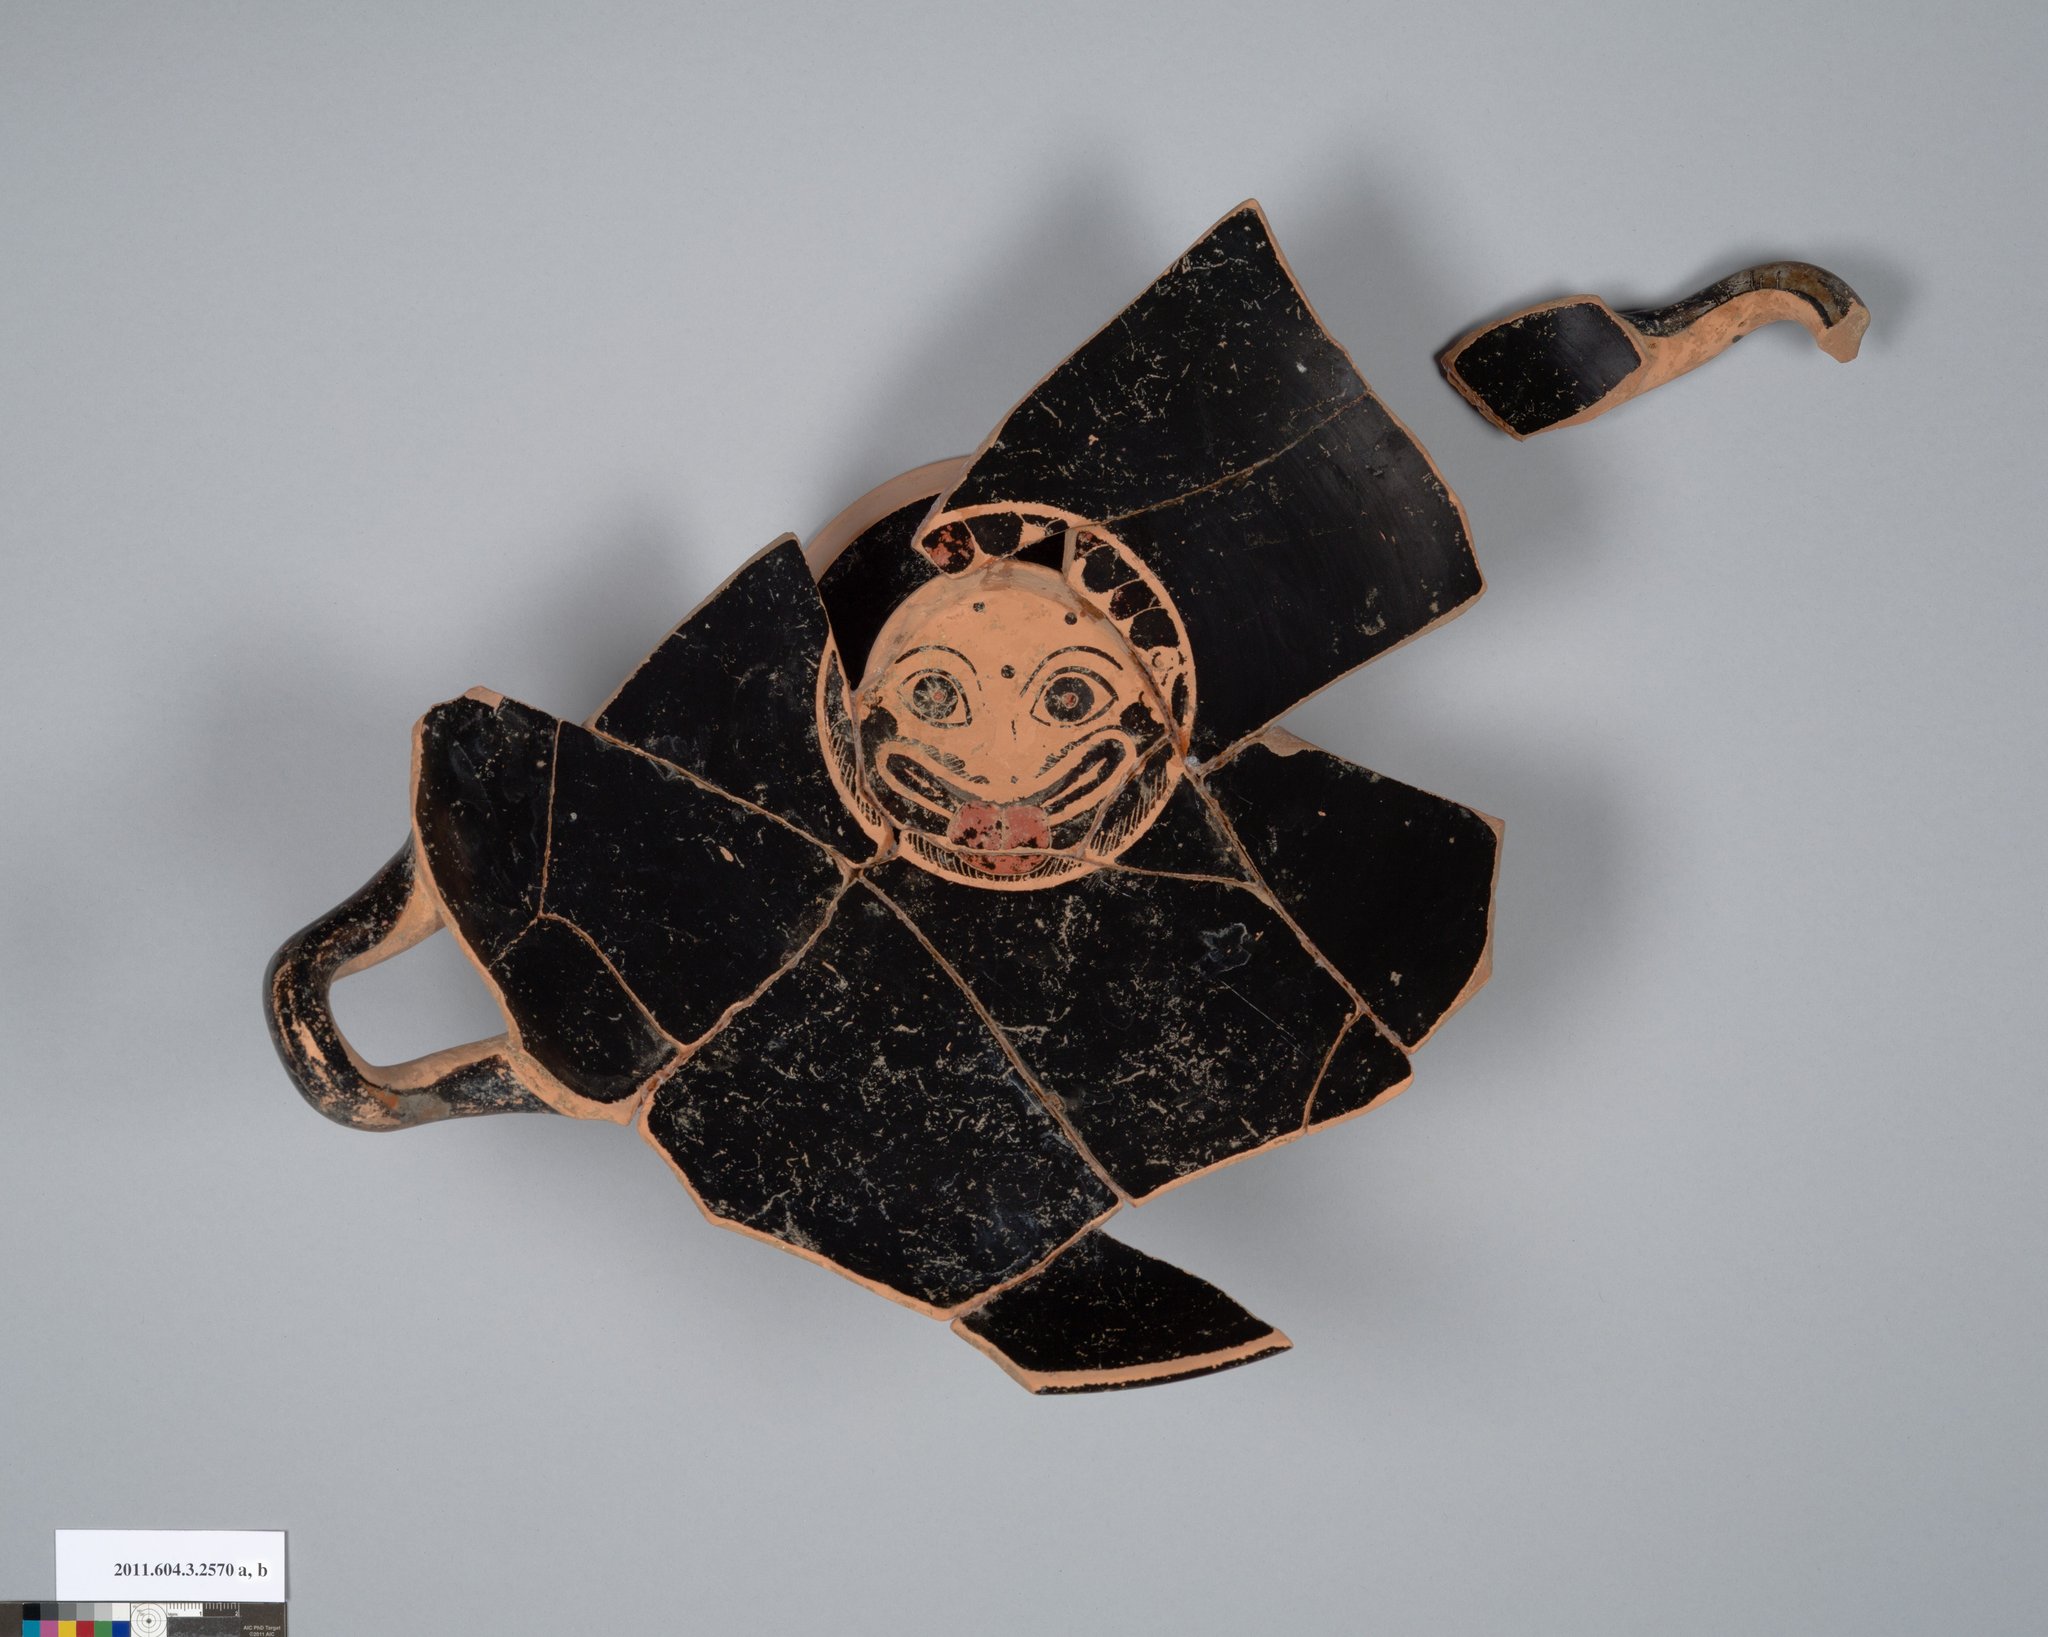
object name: kylix fragment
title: Terracotta kylix: eye-cup (drinking cup)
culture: greek, attic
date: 540-520 BCE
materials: terracotta